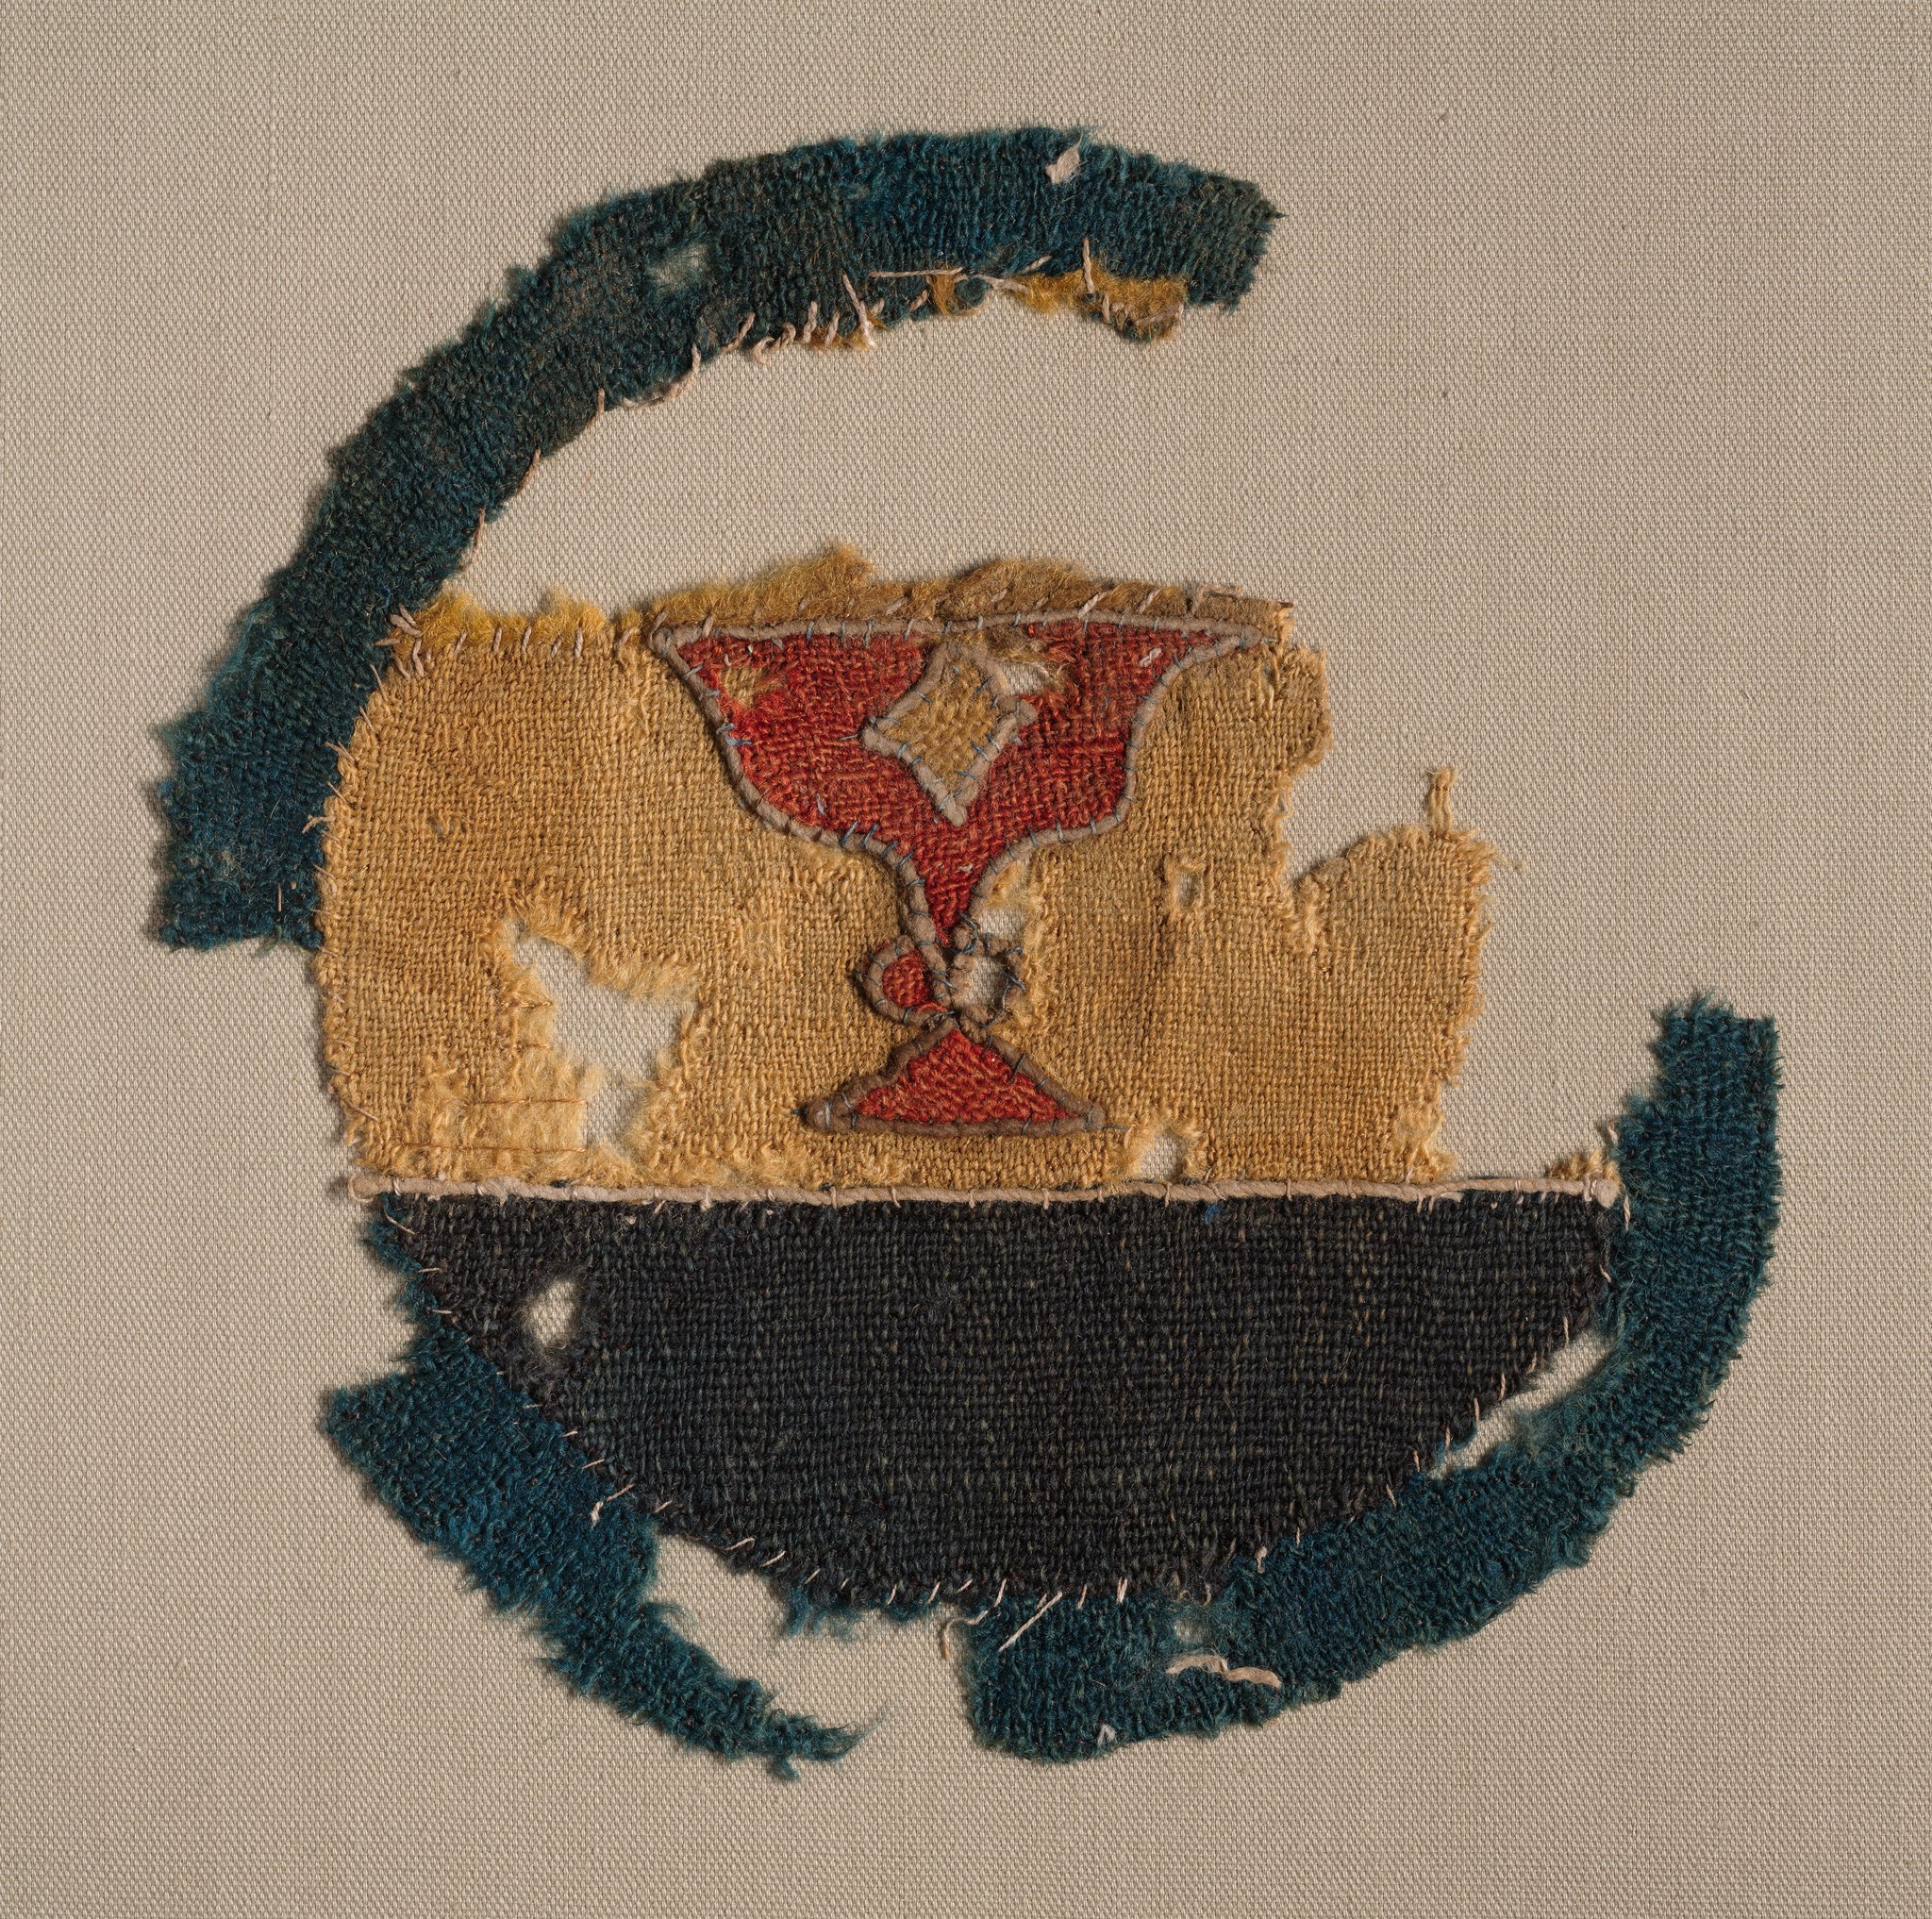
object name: textile fragment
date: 1367-1466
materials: wool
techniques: embroidery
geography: egypt